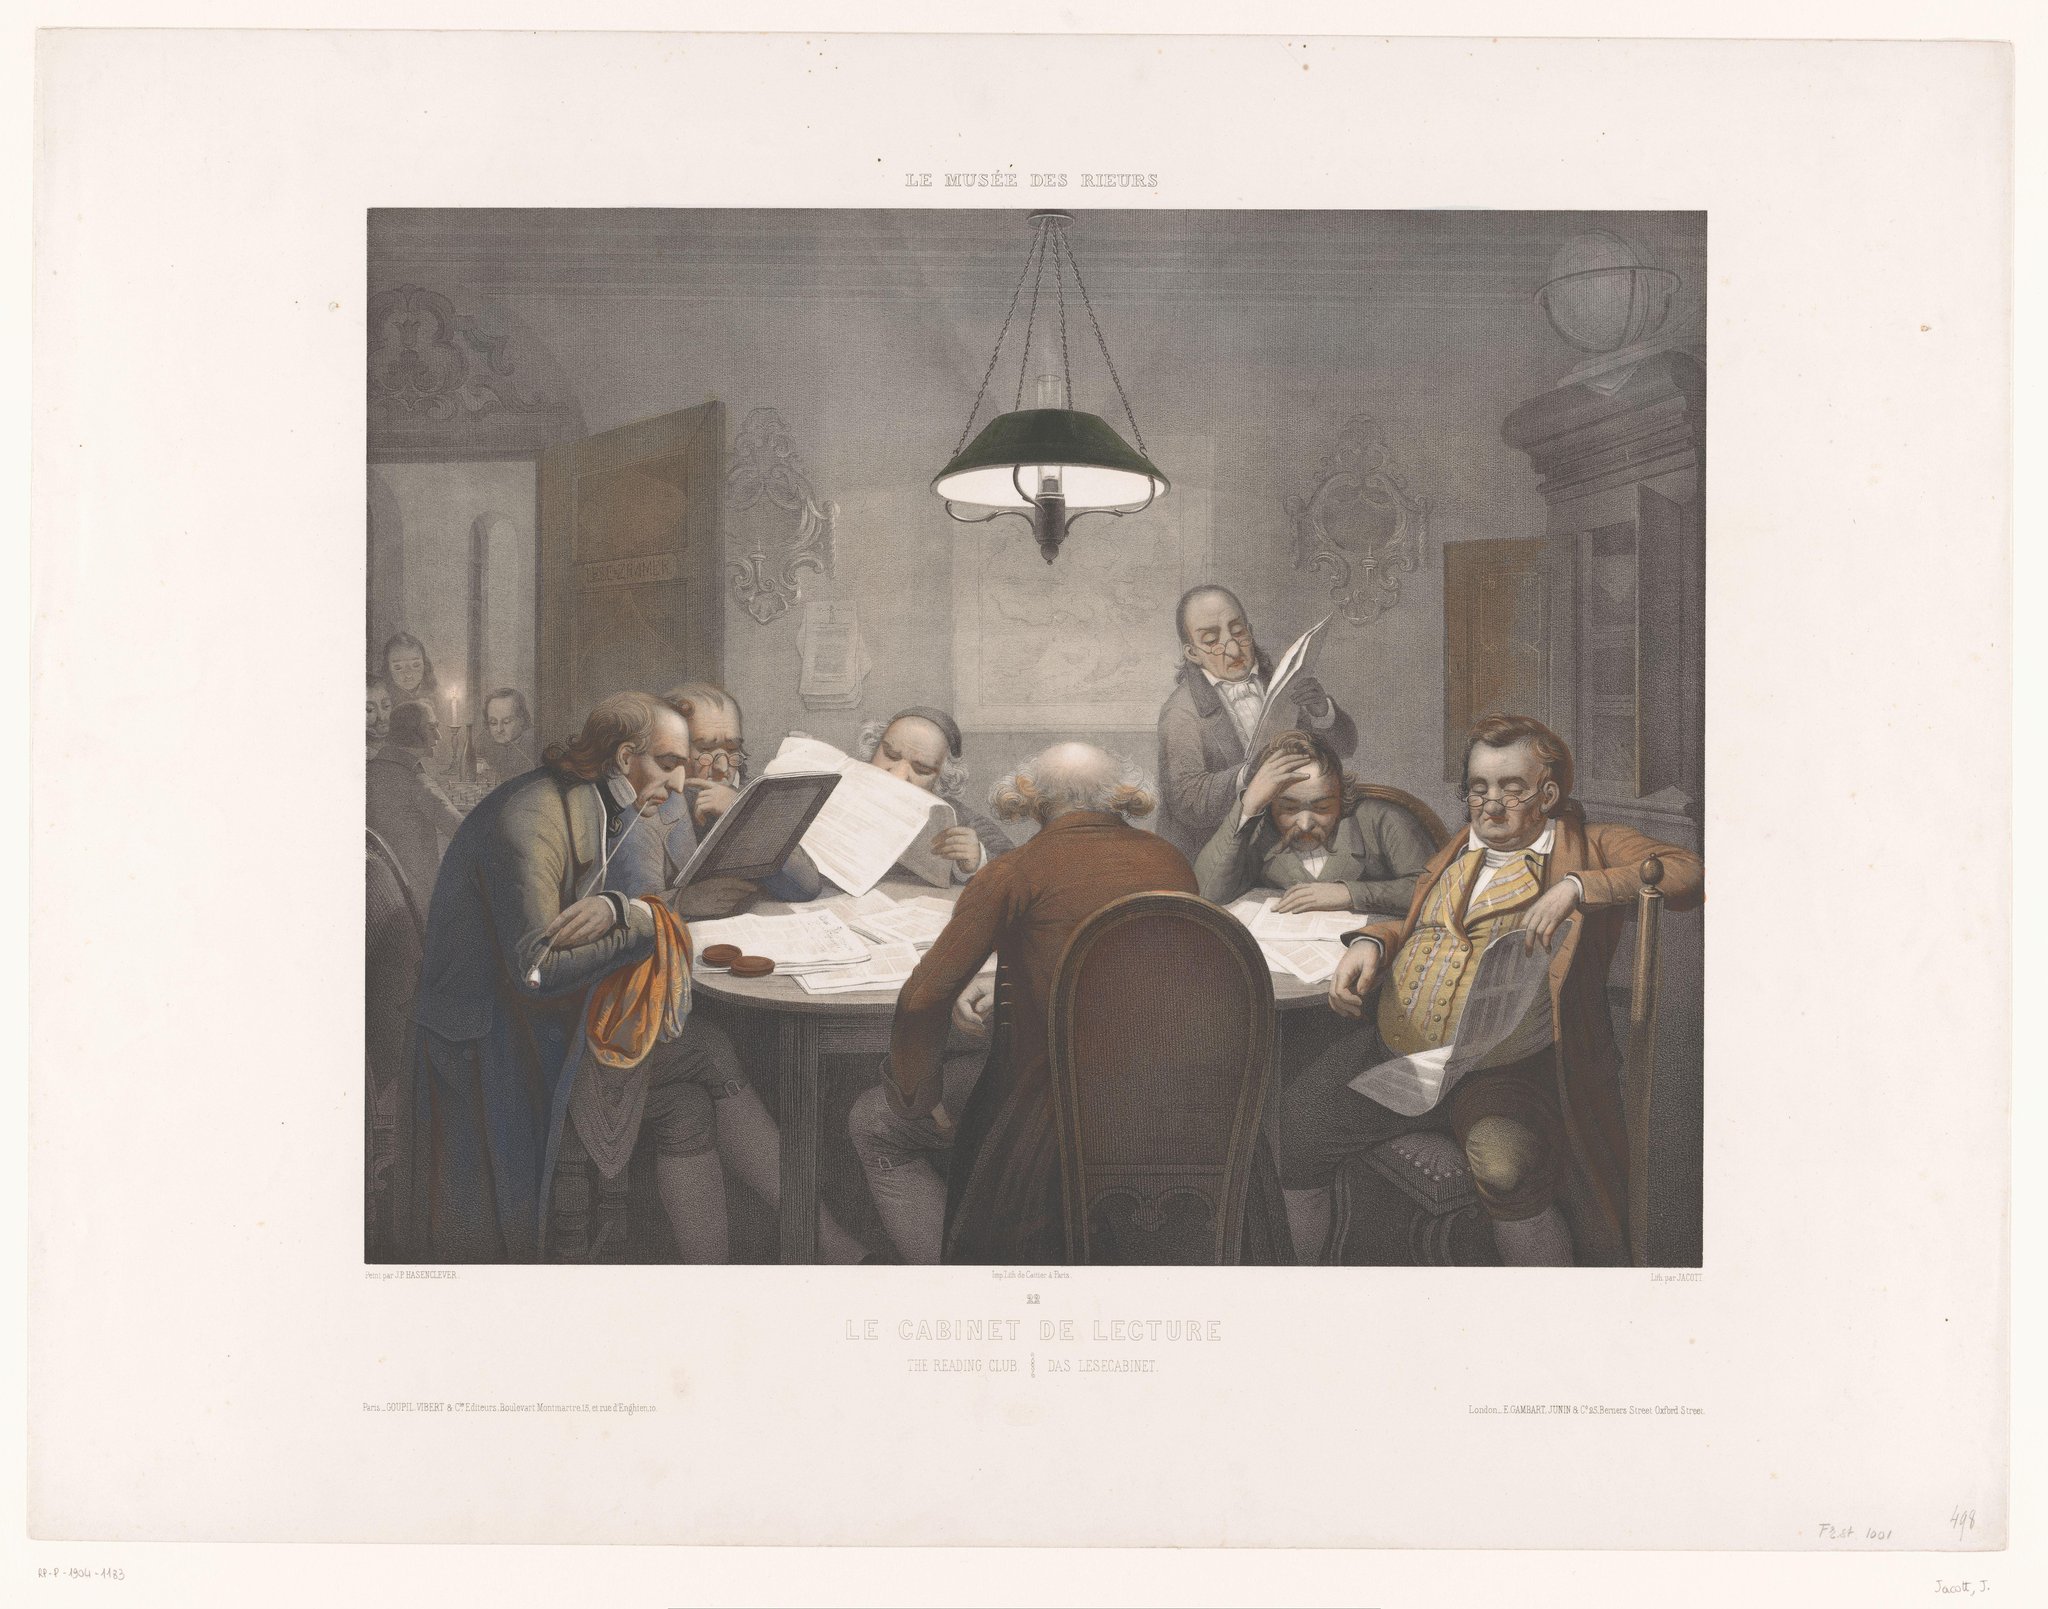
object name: print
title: Museum van de lachers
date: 1847-1851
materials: paper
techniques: hand coloring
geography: paris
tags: club, meeting place, reading, indoor recreation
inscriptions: collector's mark: Lugt 2228, check stamp: Lugt 1090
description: Leeskabinet: in een ruimte een ronde tafel waarom een gezelschap mannen kranten zit te lezen bij het licht van een lamp midden boven de tafel. De linkerman rookt een lange pijp. Door een open deur een tweede vertrek te zien waar bij kaarslicht wordt geschaakt.